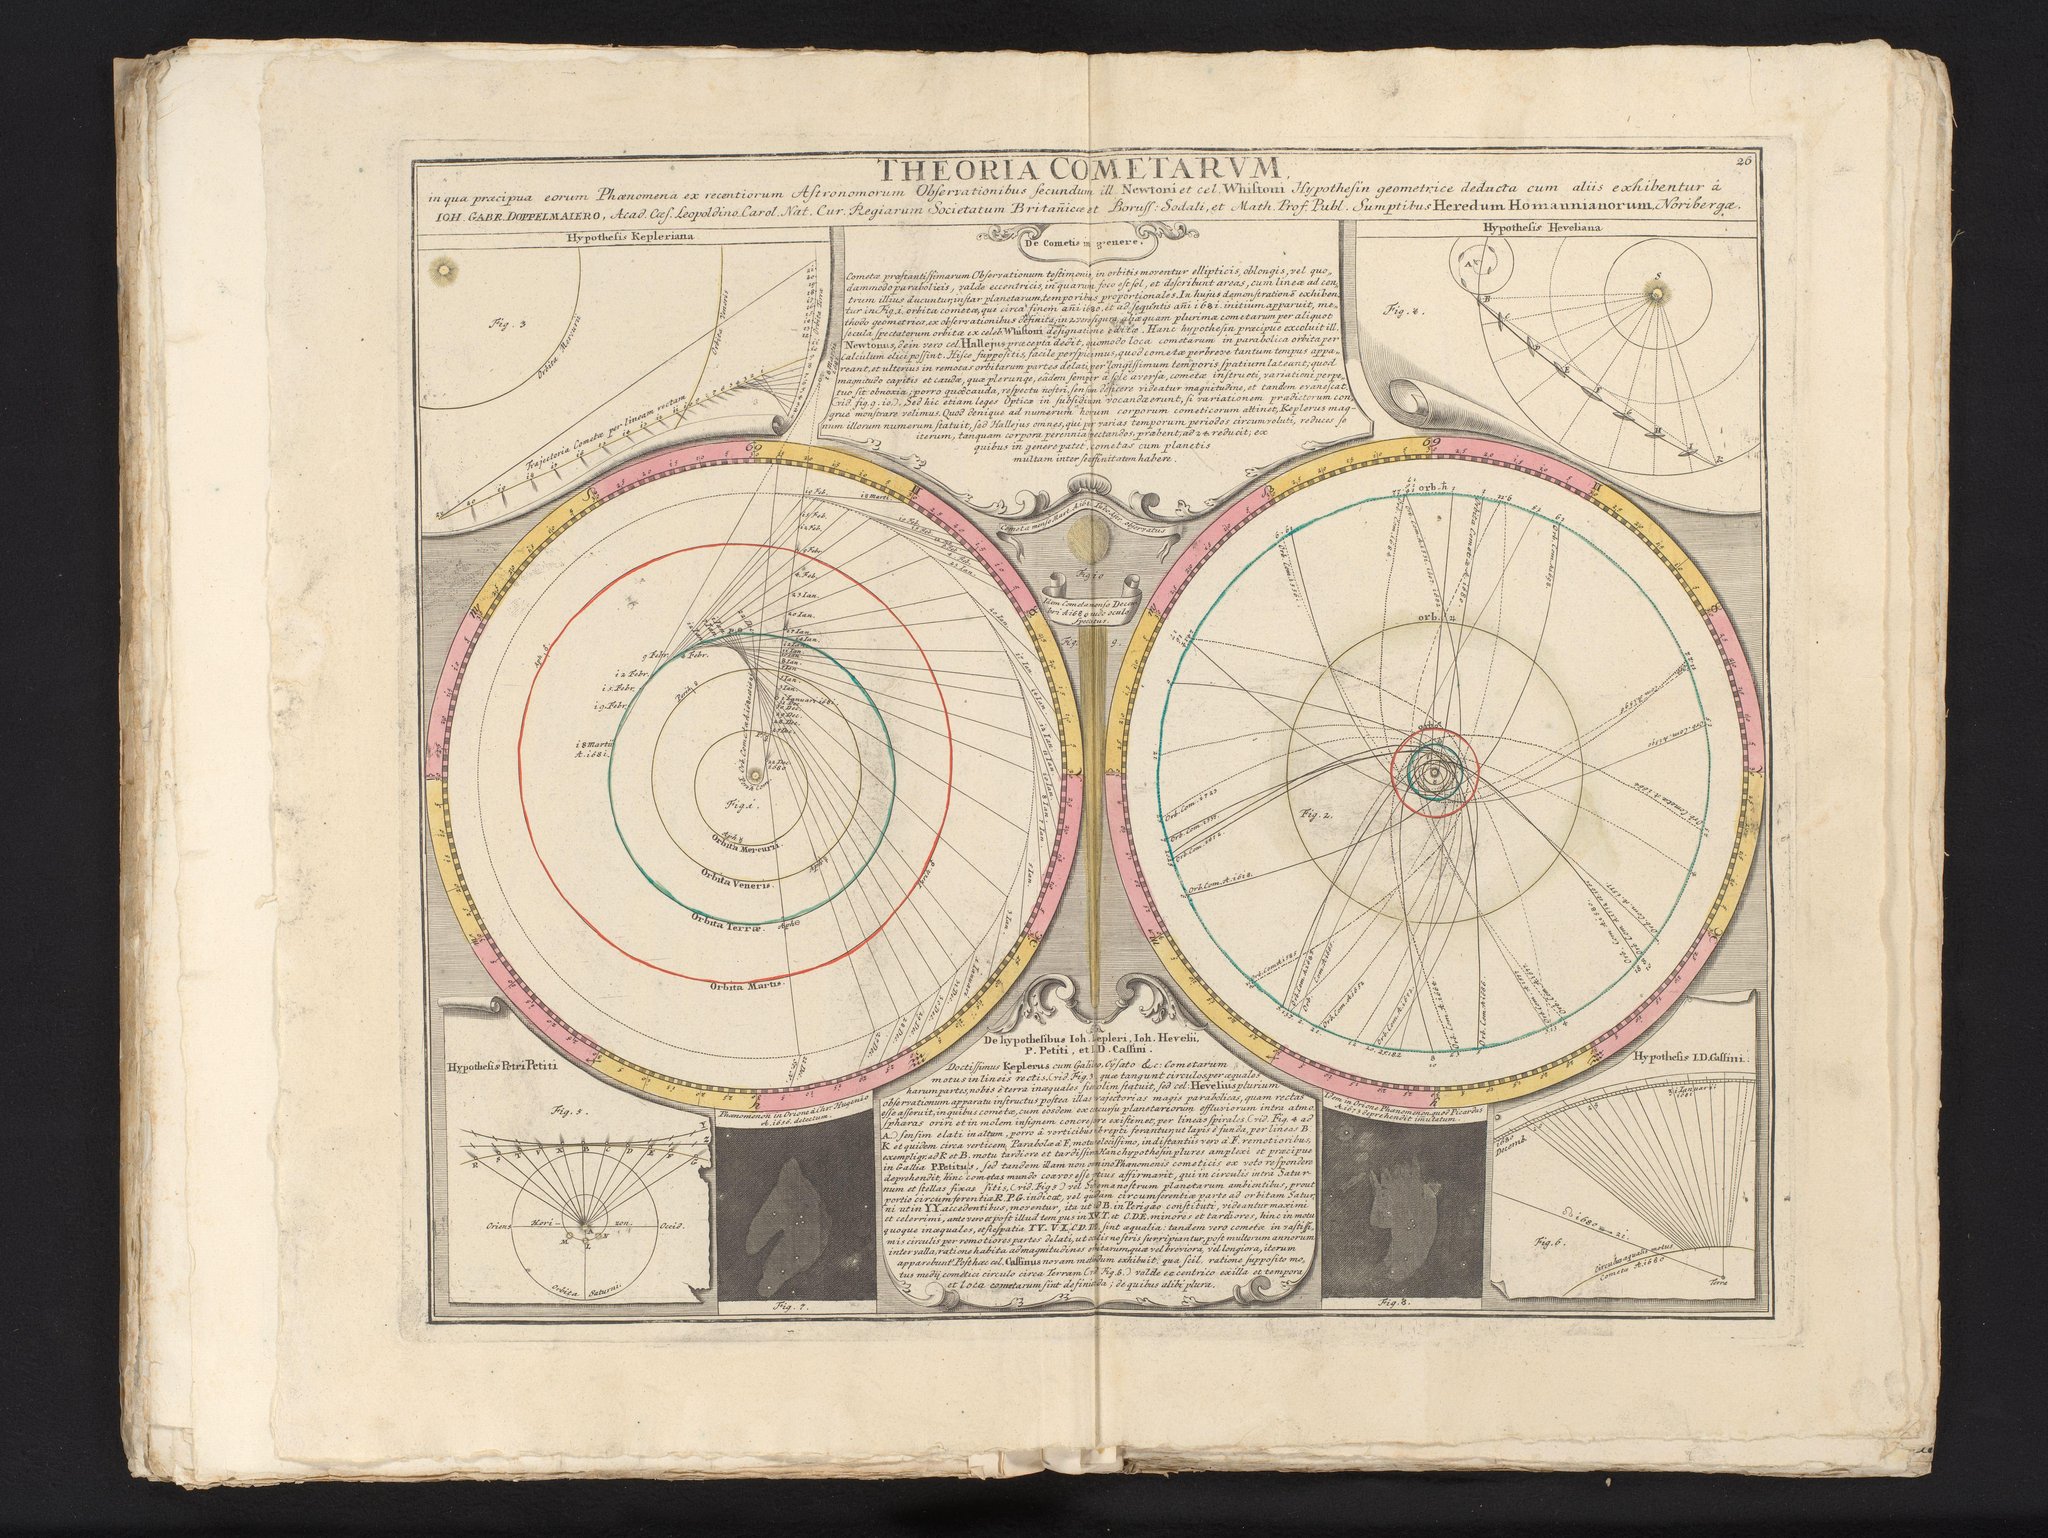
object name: print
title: Theorieën en uitleg over kometen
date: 1742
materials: paper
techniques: engraving, etching, hand coloring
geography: nuremberg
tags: comet, star-chart, star map